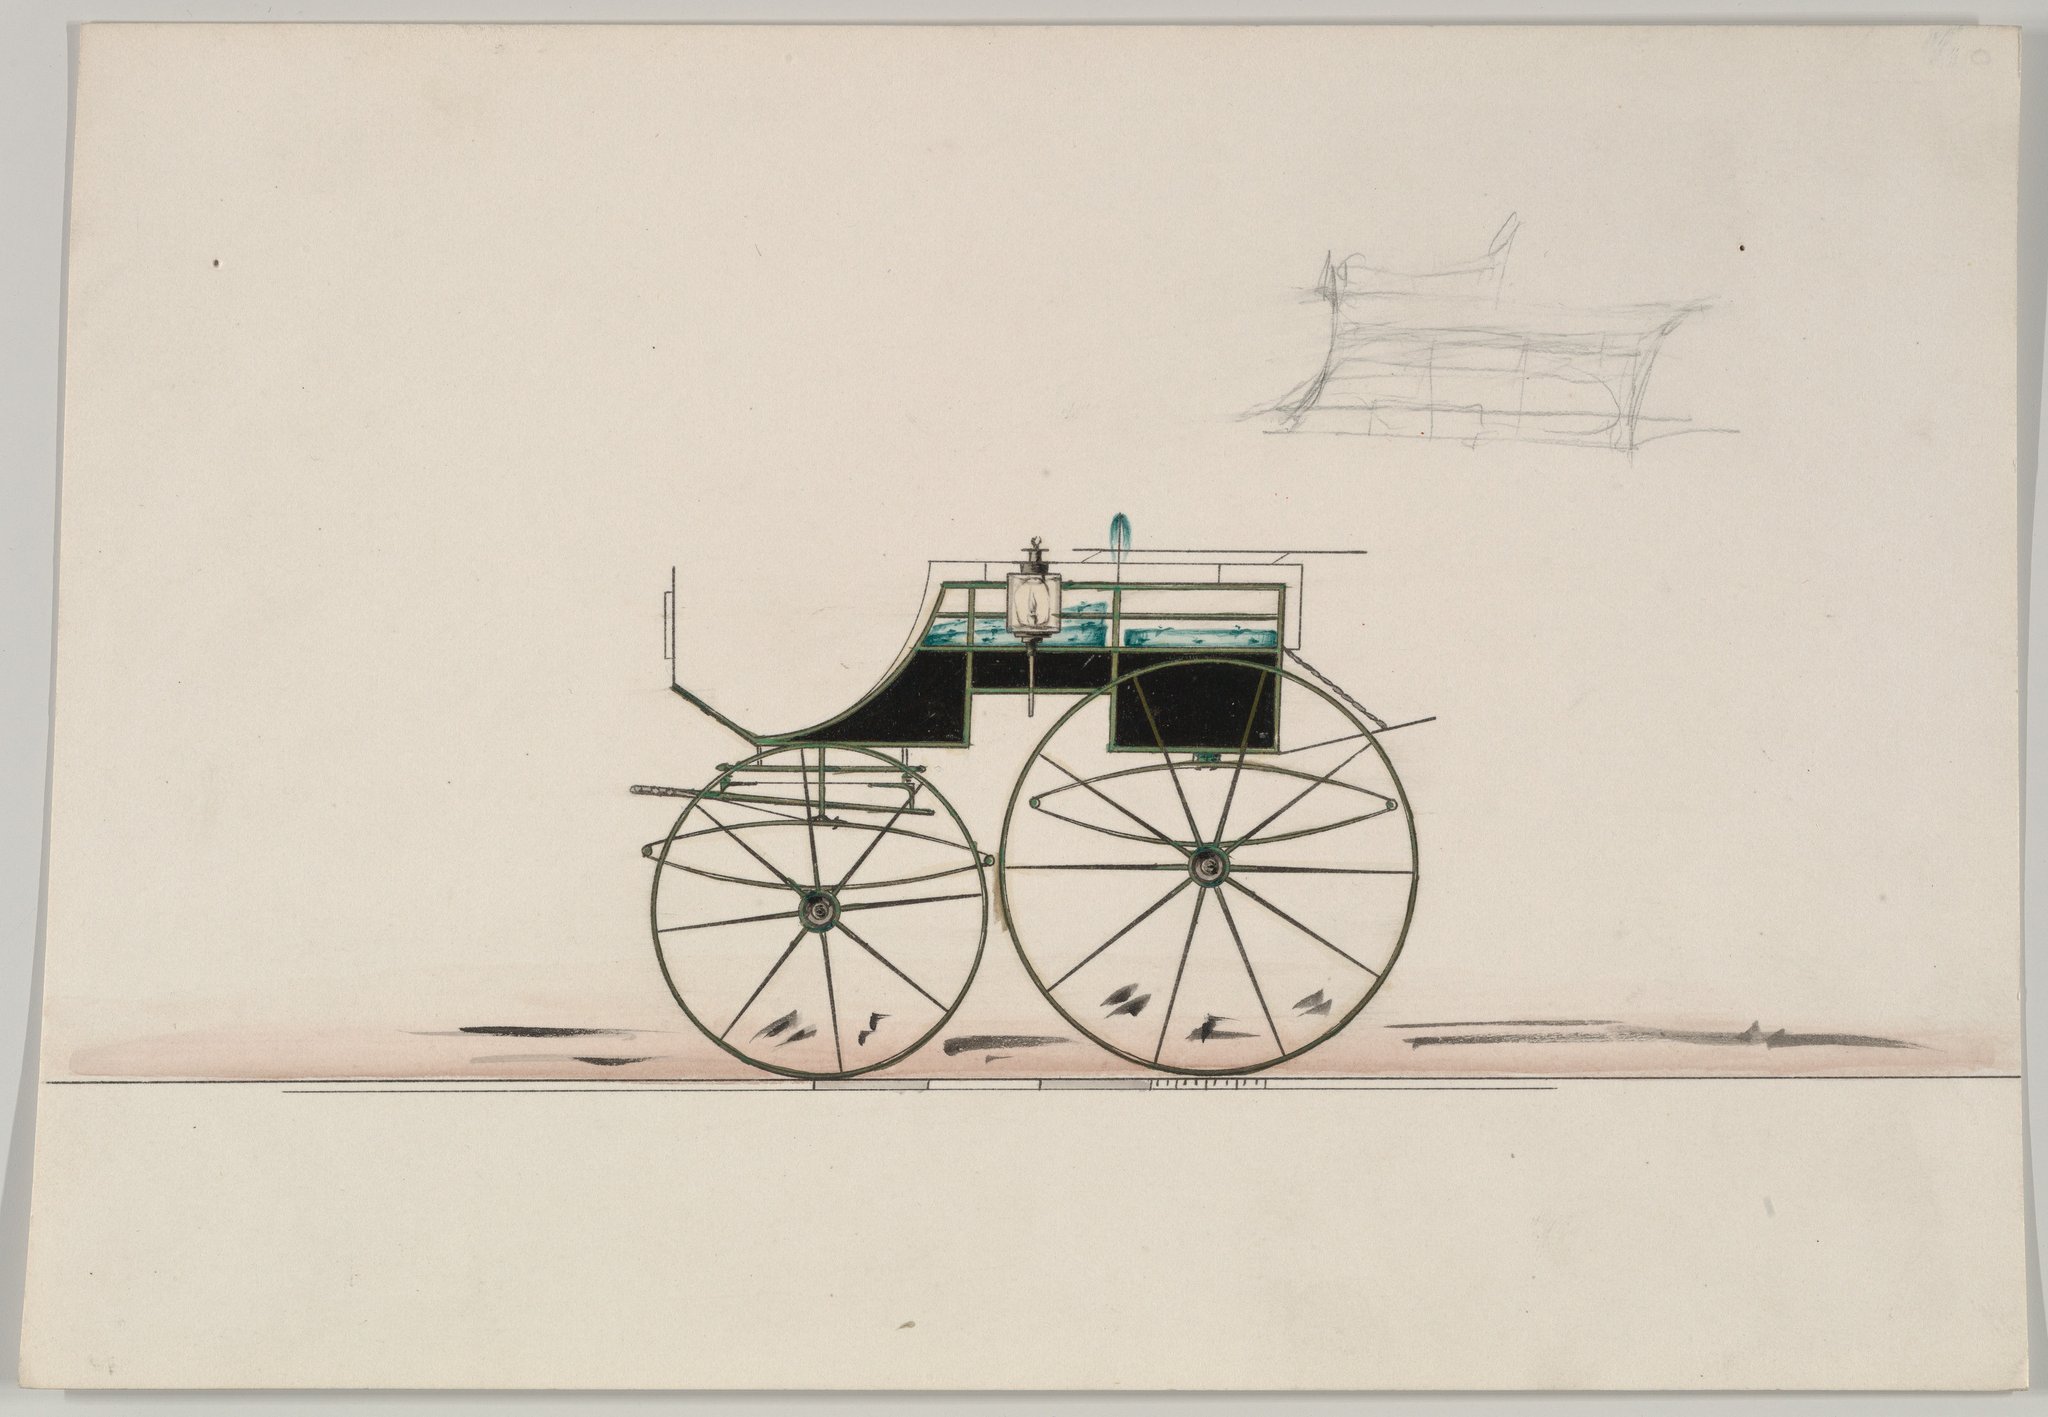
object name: drawing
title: Phaeton, no top (unnumbered)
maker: brewster & co.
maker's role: manufacturer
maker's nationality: american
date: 1850-1870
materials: gouache, gum arabic, ink, watercolor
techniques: pen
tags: carriages